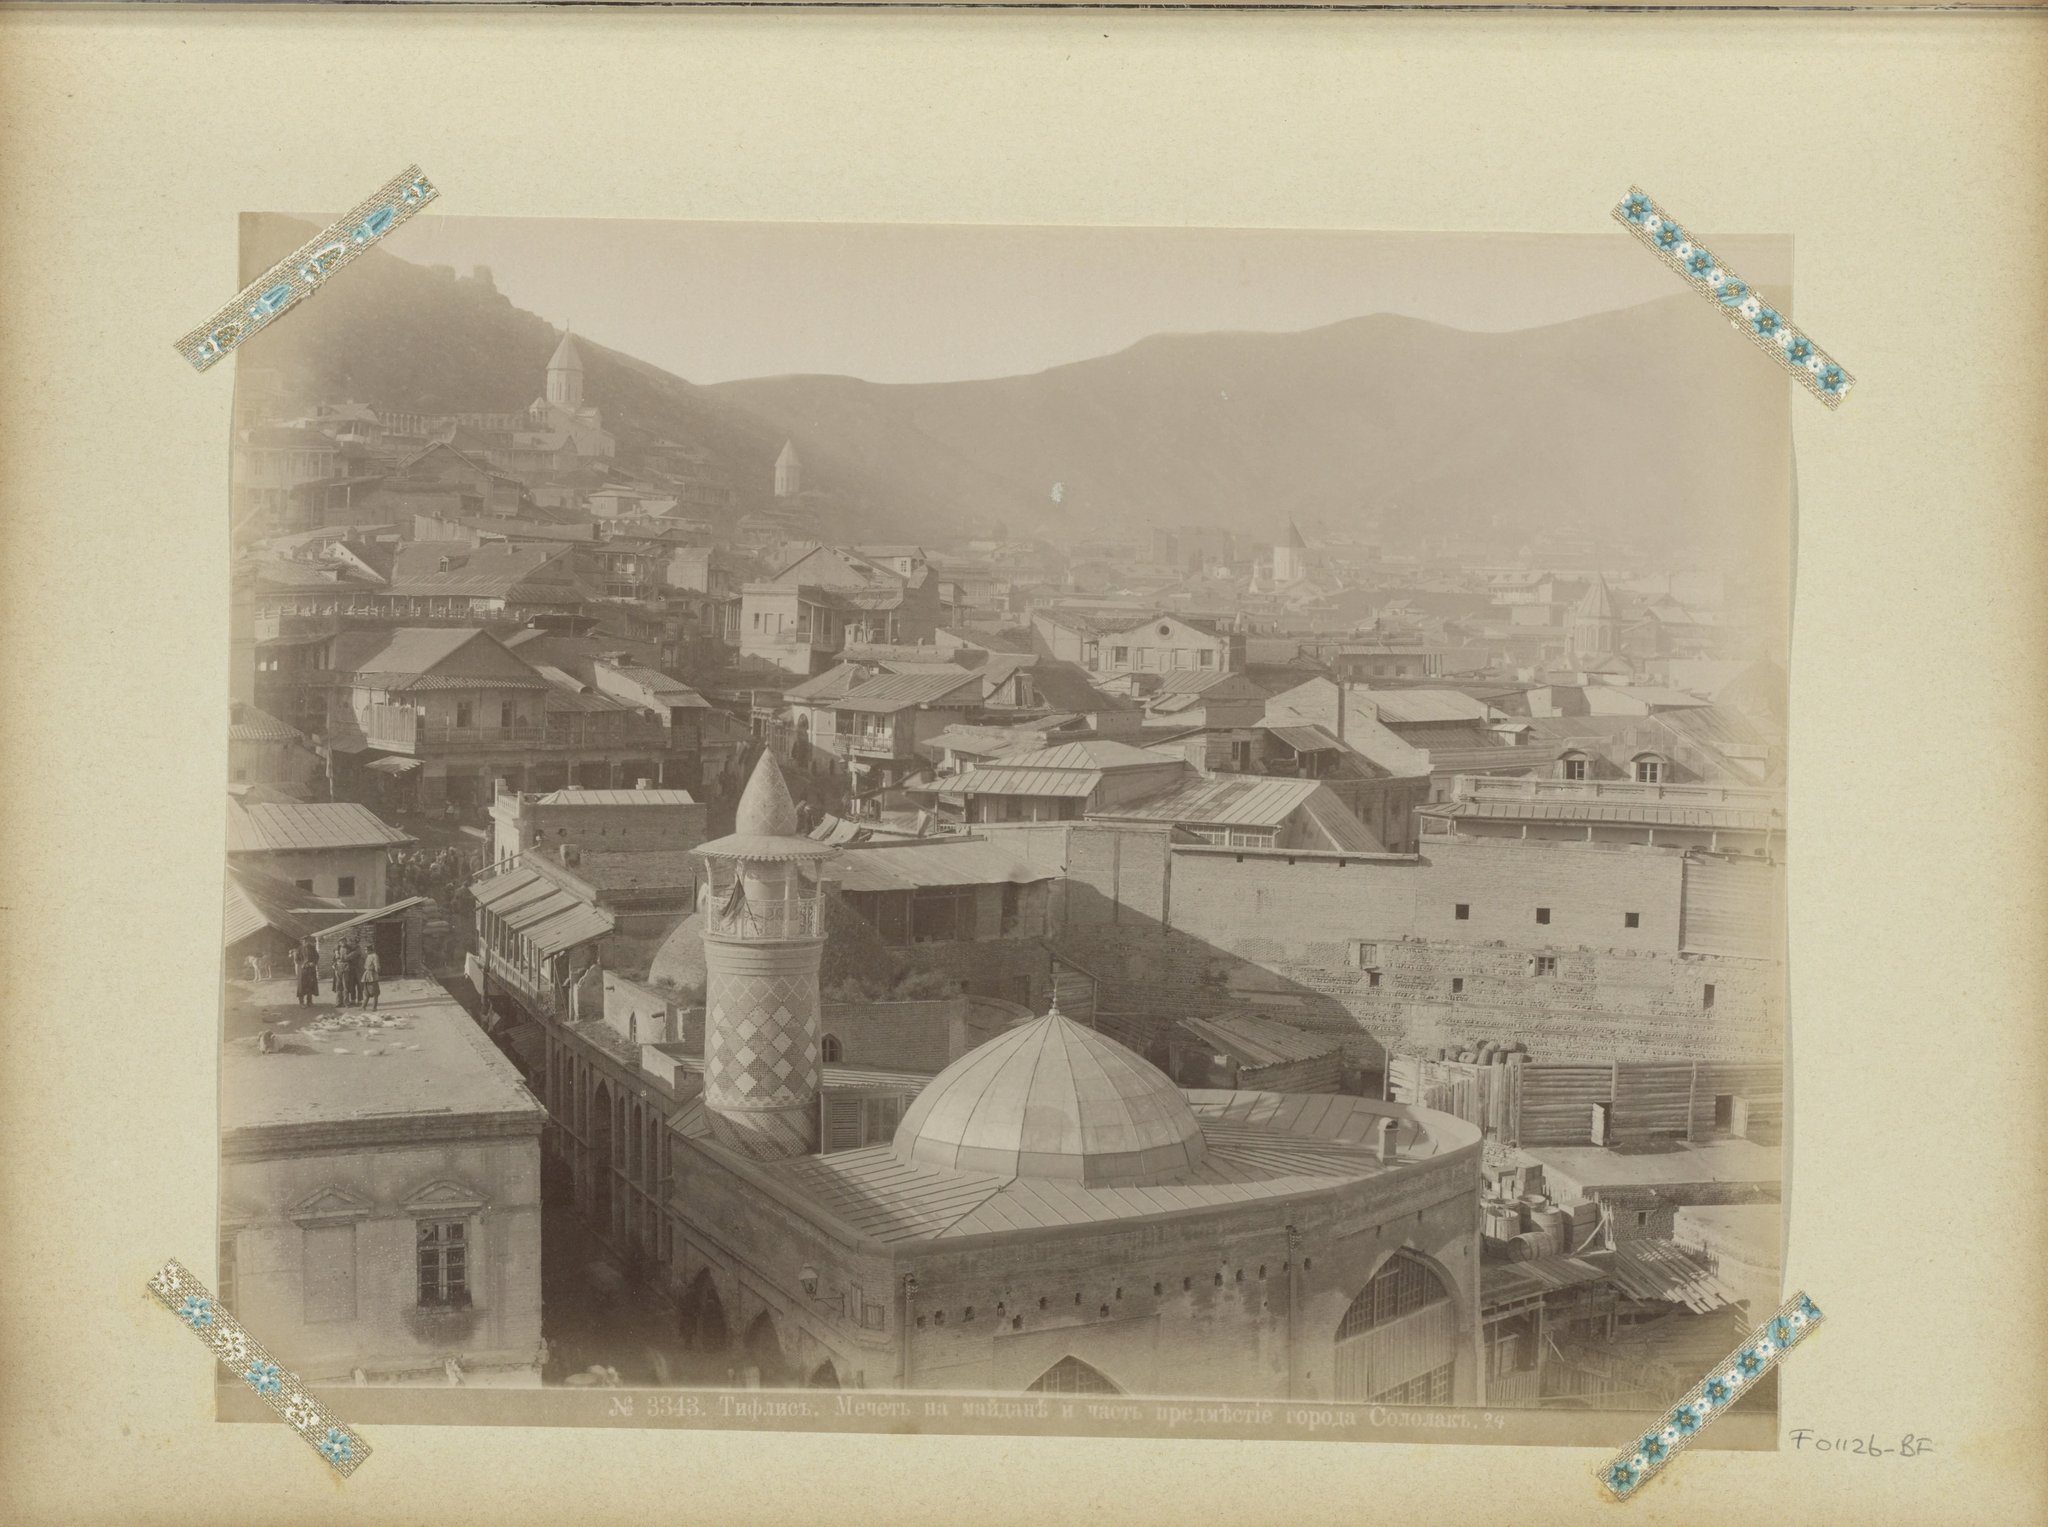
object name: photograph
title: Gezicht op Tiflis met kerken en op de voorgrond een moskee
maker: Anonymous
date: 1890-1900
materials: photographic support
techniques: albumen print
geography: tbilisi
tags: church (exterior), temple, shrine ~ islam, mohammedanism, prospect of city, town panorama, silhouette of city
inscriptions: number: ‘3343’, number: ‘24’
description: Onderdeel van Fotoalbum met opnames van bezienswaardigheden in Georgië, Sint-Petersburg en Moskou.